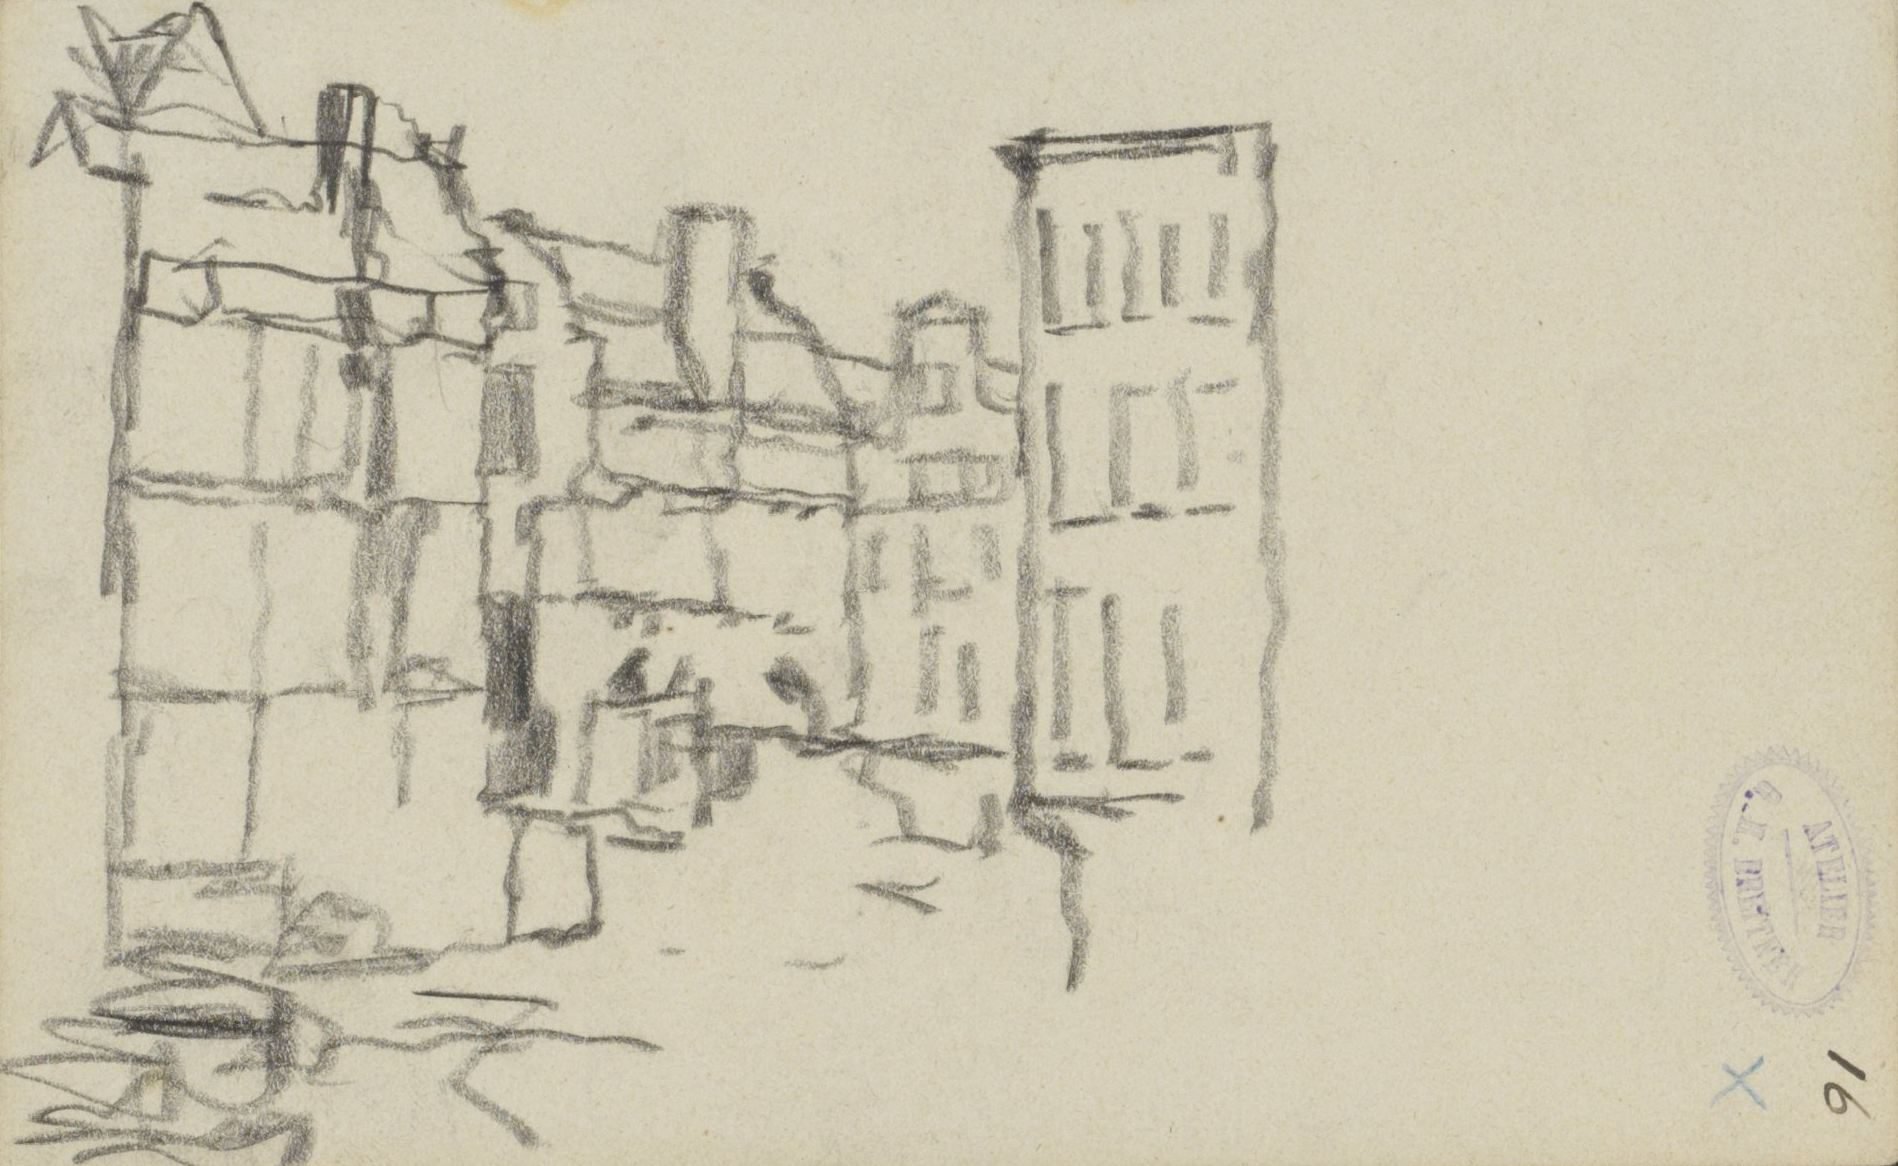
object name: drawing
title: Afbraak van oude gebouwen te Amsterdam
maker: george hendrik breitner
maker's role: draughtsman, painter, print maker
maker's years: 1857-1923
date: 1912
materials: chalk, paper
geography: amsterdam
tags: urban housing, demolition of building, amsterdam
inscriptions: workshop stamp: Lugt 291d, collector's mark: Lugt 2228